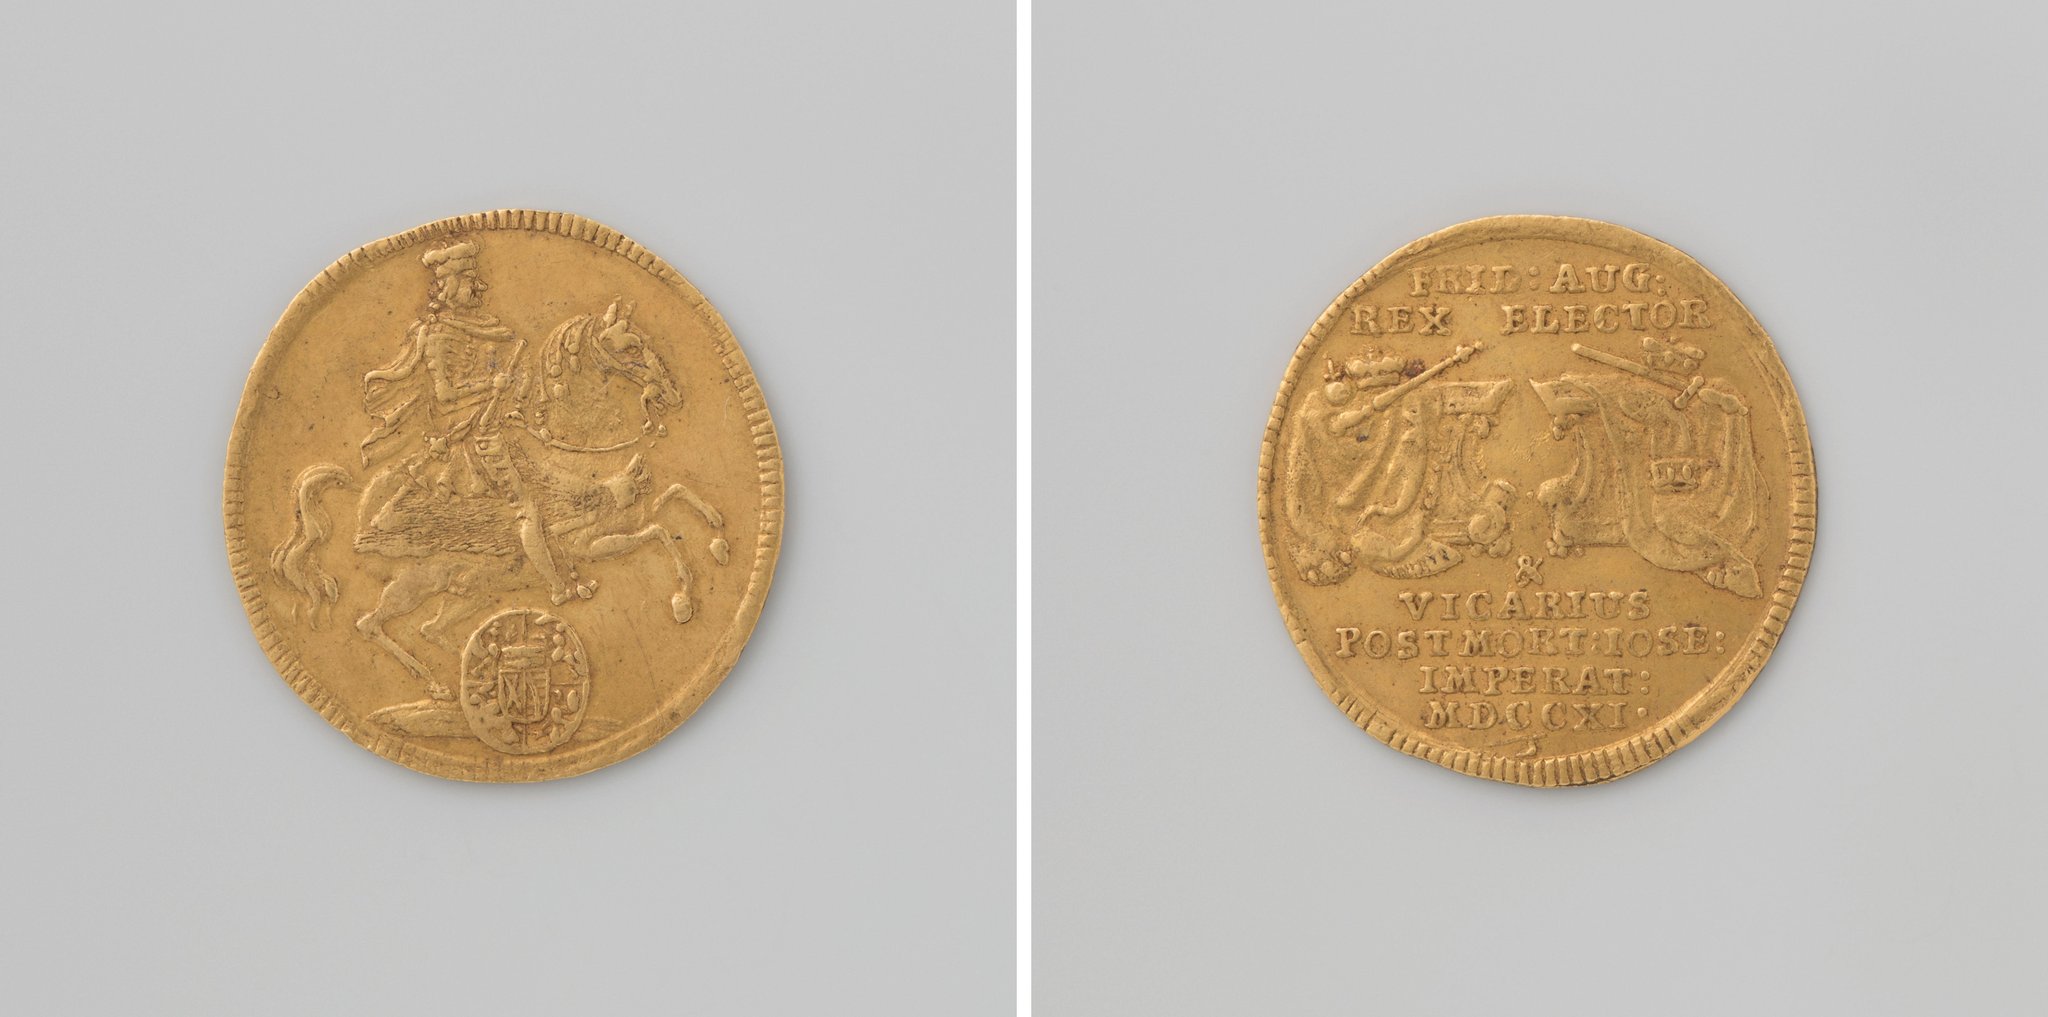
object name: history medal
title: Frederik Augustus, koning van Polen en keurvorst van Saksen aangesteld tot stadhouder van het Roomse Rijk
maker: johann lorenz holland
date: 1711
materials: gold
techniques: striking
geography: dresden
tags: august ii (king of poland)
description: Gouden penning. Voorzijde: portret ruiter met kroon en commandostaf boven wapenschild. Keerzijde: op linker tafel ligt keizerskroon, scepter en rijksappel, op rechter keurvorstelijke muts en degen tussen opschriften